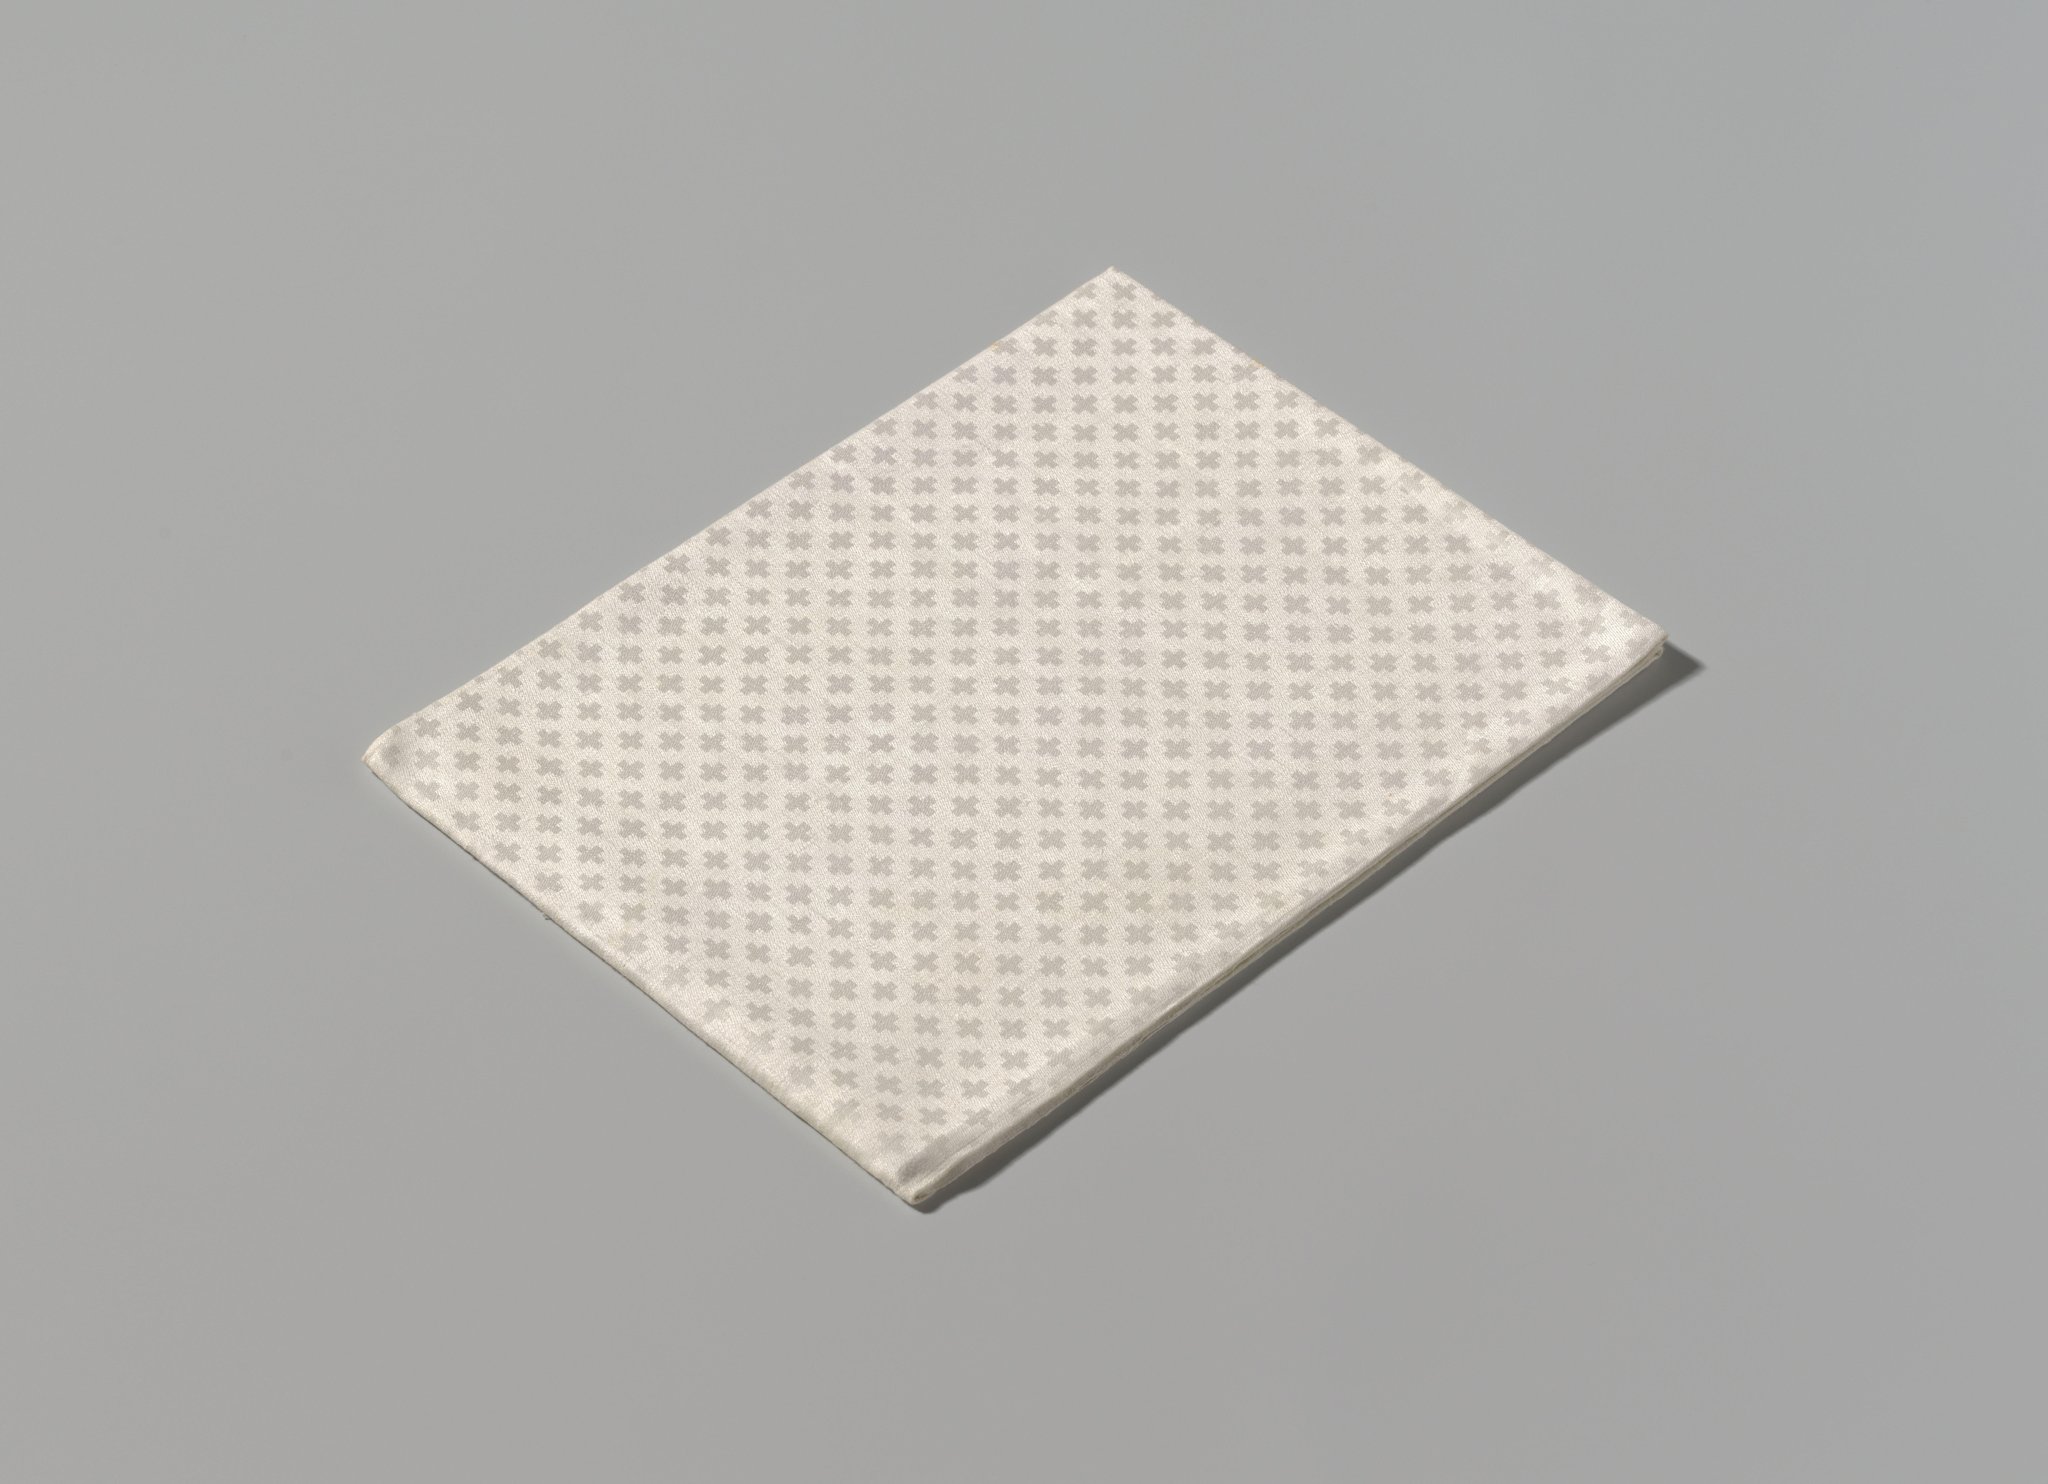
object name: napkin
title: Servet van linnen met pellenpatroon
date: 1800-1866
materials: linen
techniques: peeled fabric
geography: northern netherlands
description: Wit linnen servet met een pellen patroon. Merk HP 84.